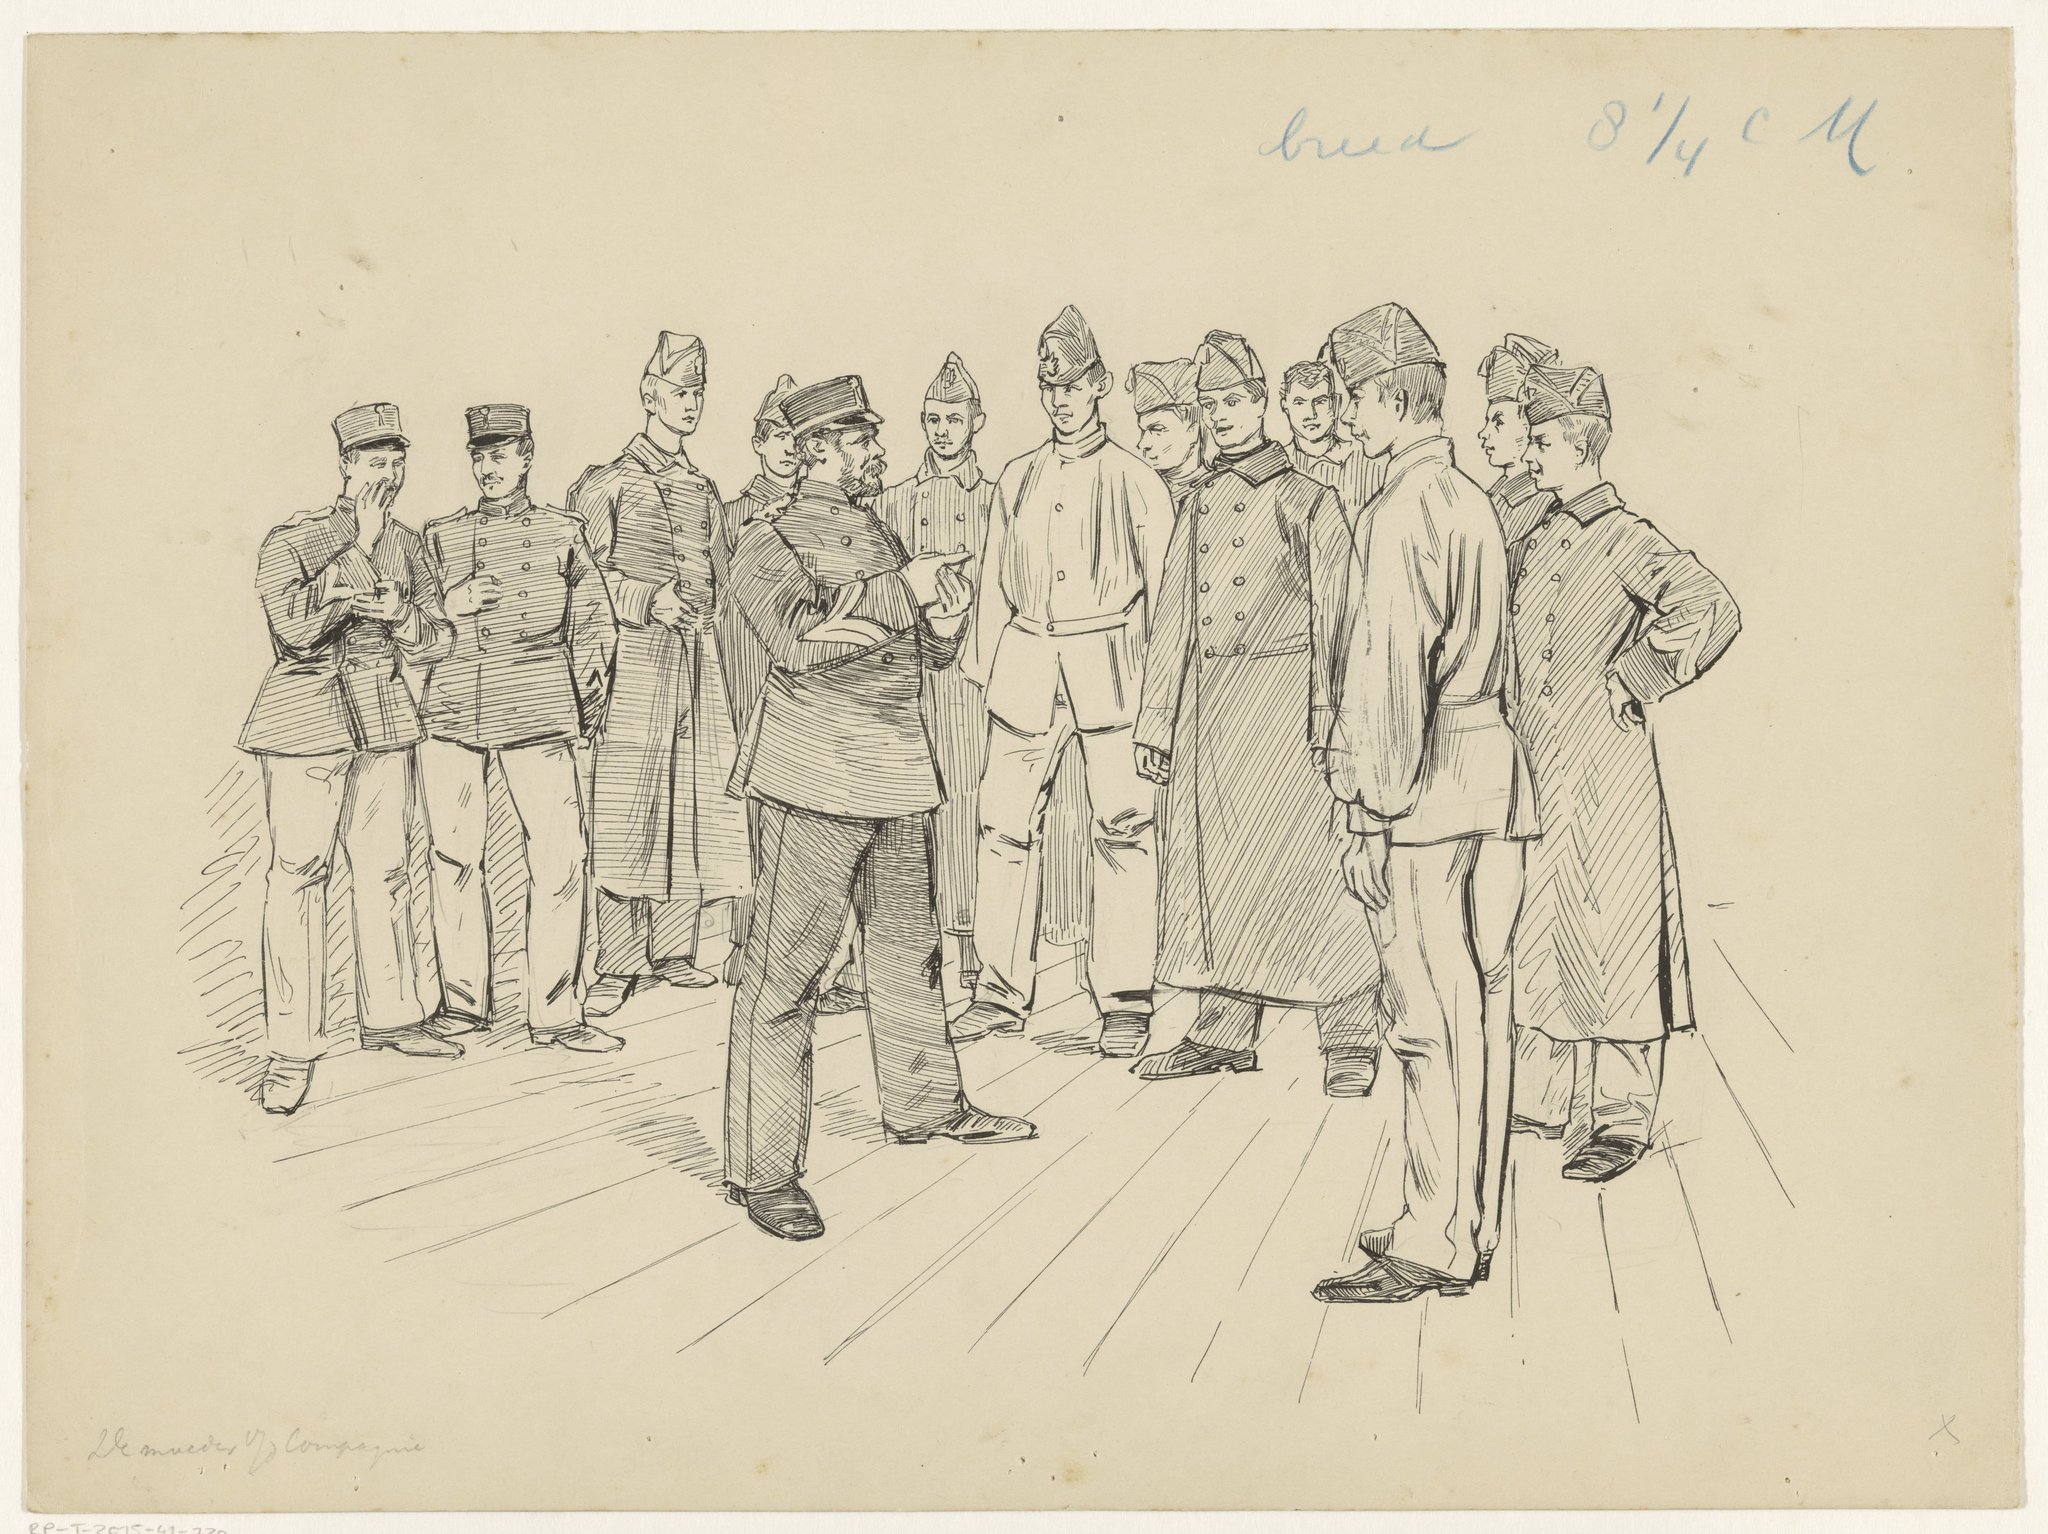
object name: boekillustratie ontwerp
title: Compagnie in een halve cirkel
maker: heinrich m. krabbé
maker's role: draughtsman, print maker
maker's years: 1868-1931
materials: ink, paper, pencil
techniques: pen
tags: the soldier; the soldier's life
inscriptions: annotation: ‘De moeder v/d Compagnie’, :, collector's mark: Lugt 2228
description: Een groep soldaten staat in een halve cirkel te luisteren naar een man in uniform die één van de aanwezigen toespreekt.